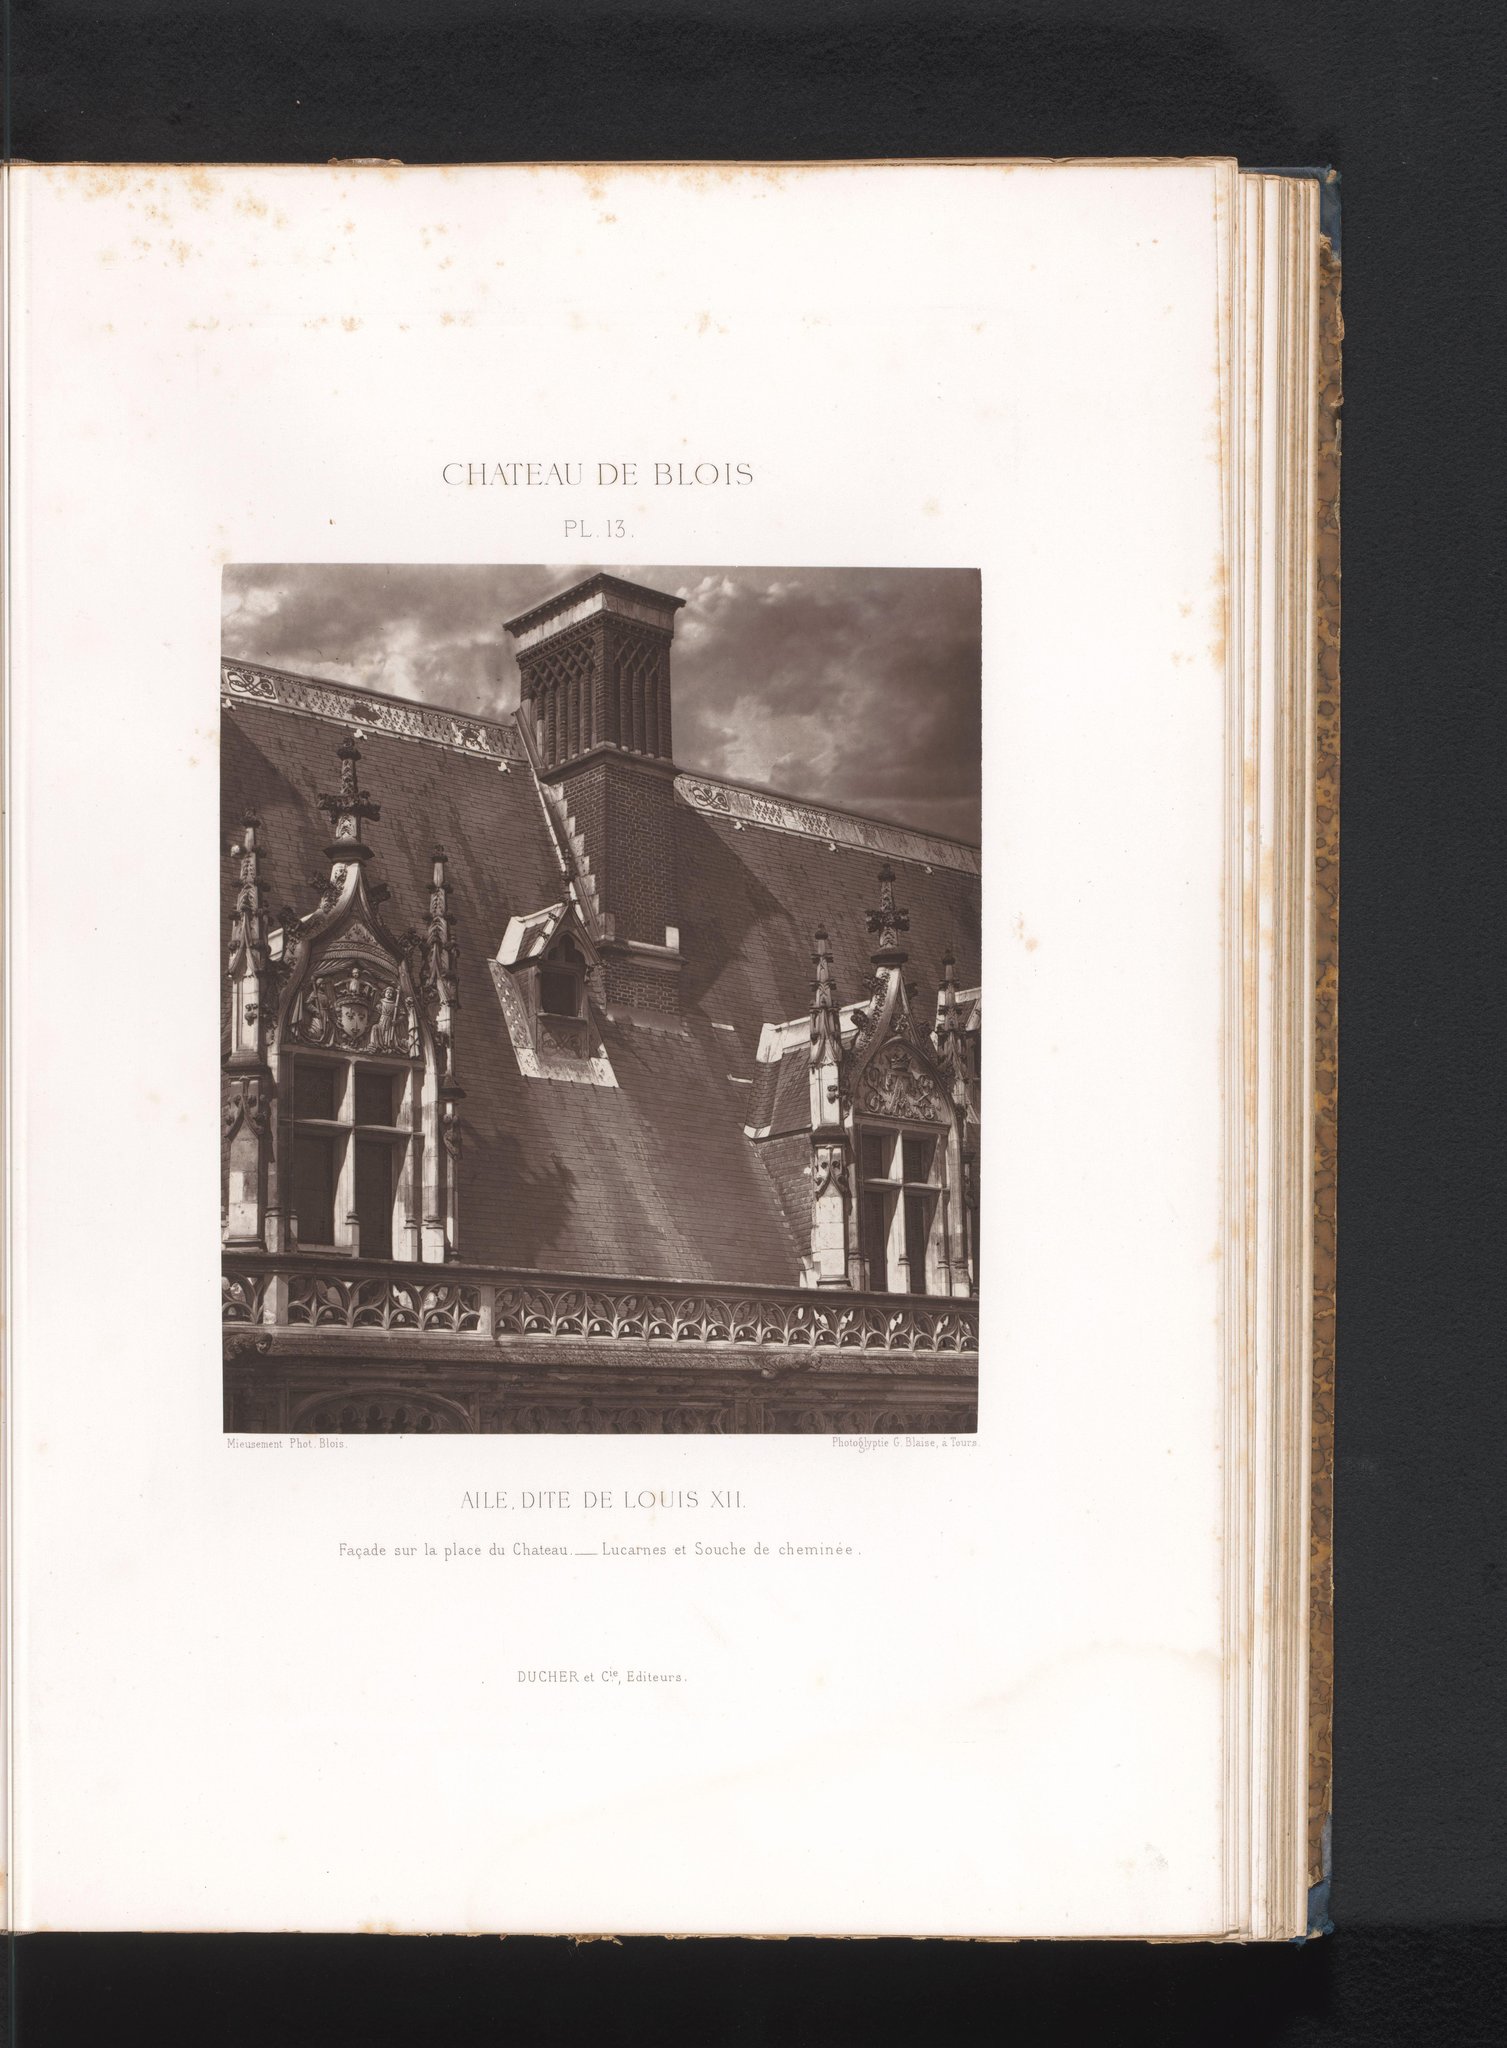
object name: page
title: Gezicht op het dak van de Lodewijk XII vleugel van het Kasteel van Blois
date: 1870-1875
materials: paper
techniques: woodburytype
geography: tours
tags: roof (of house or building), castle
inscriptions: number: ‘PL. 13.’